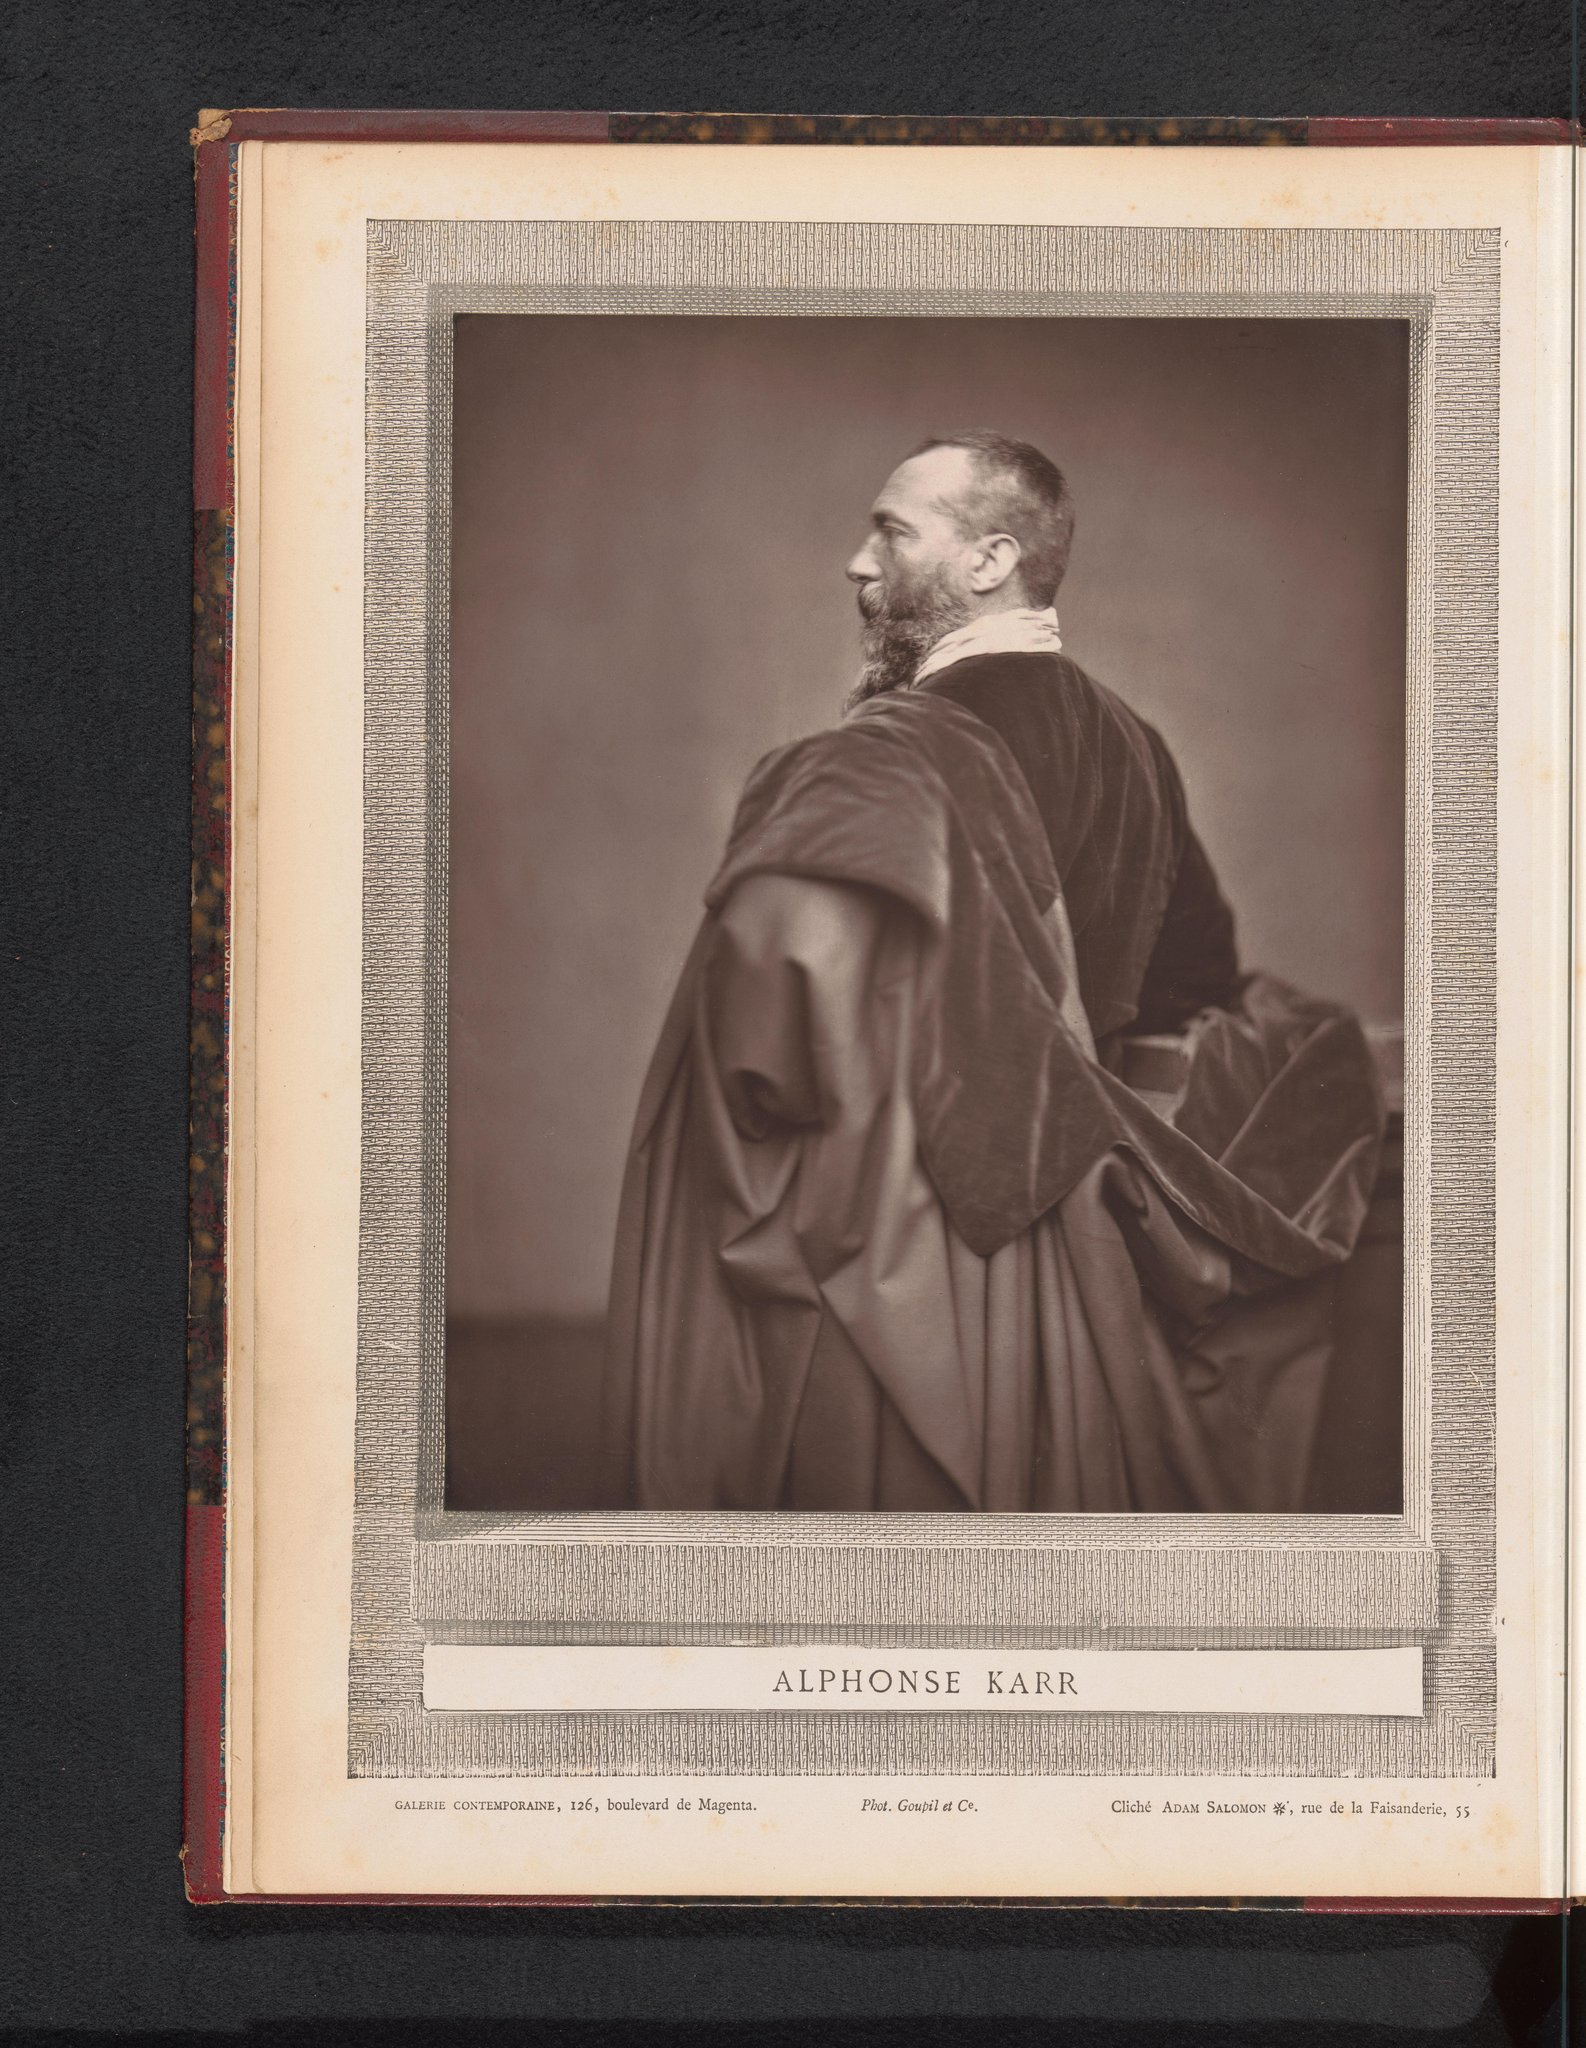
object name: page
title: Portret van Jean-Baptiste Alphonse Karr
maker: antoine-samuel adam-salomon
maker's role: sculptor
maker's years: 1818-1881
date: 1871-1876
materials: paper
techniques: woodburytype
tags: paris, alphonse karr, adult man, historical persons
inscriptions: inscription: ‘Galerie Contemporaine, 126, boulevard de Magenta.’